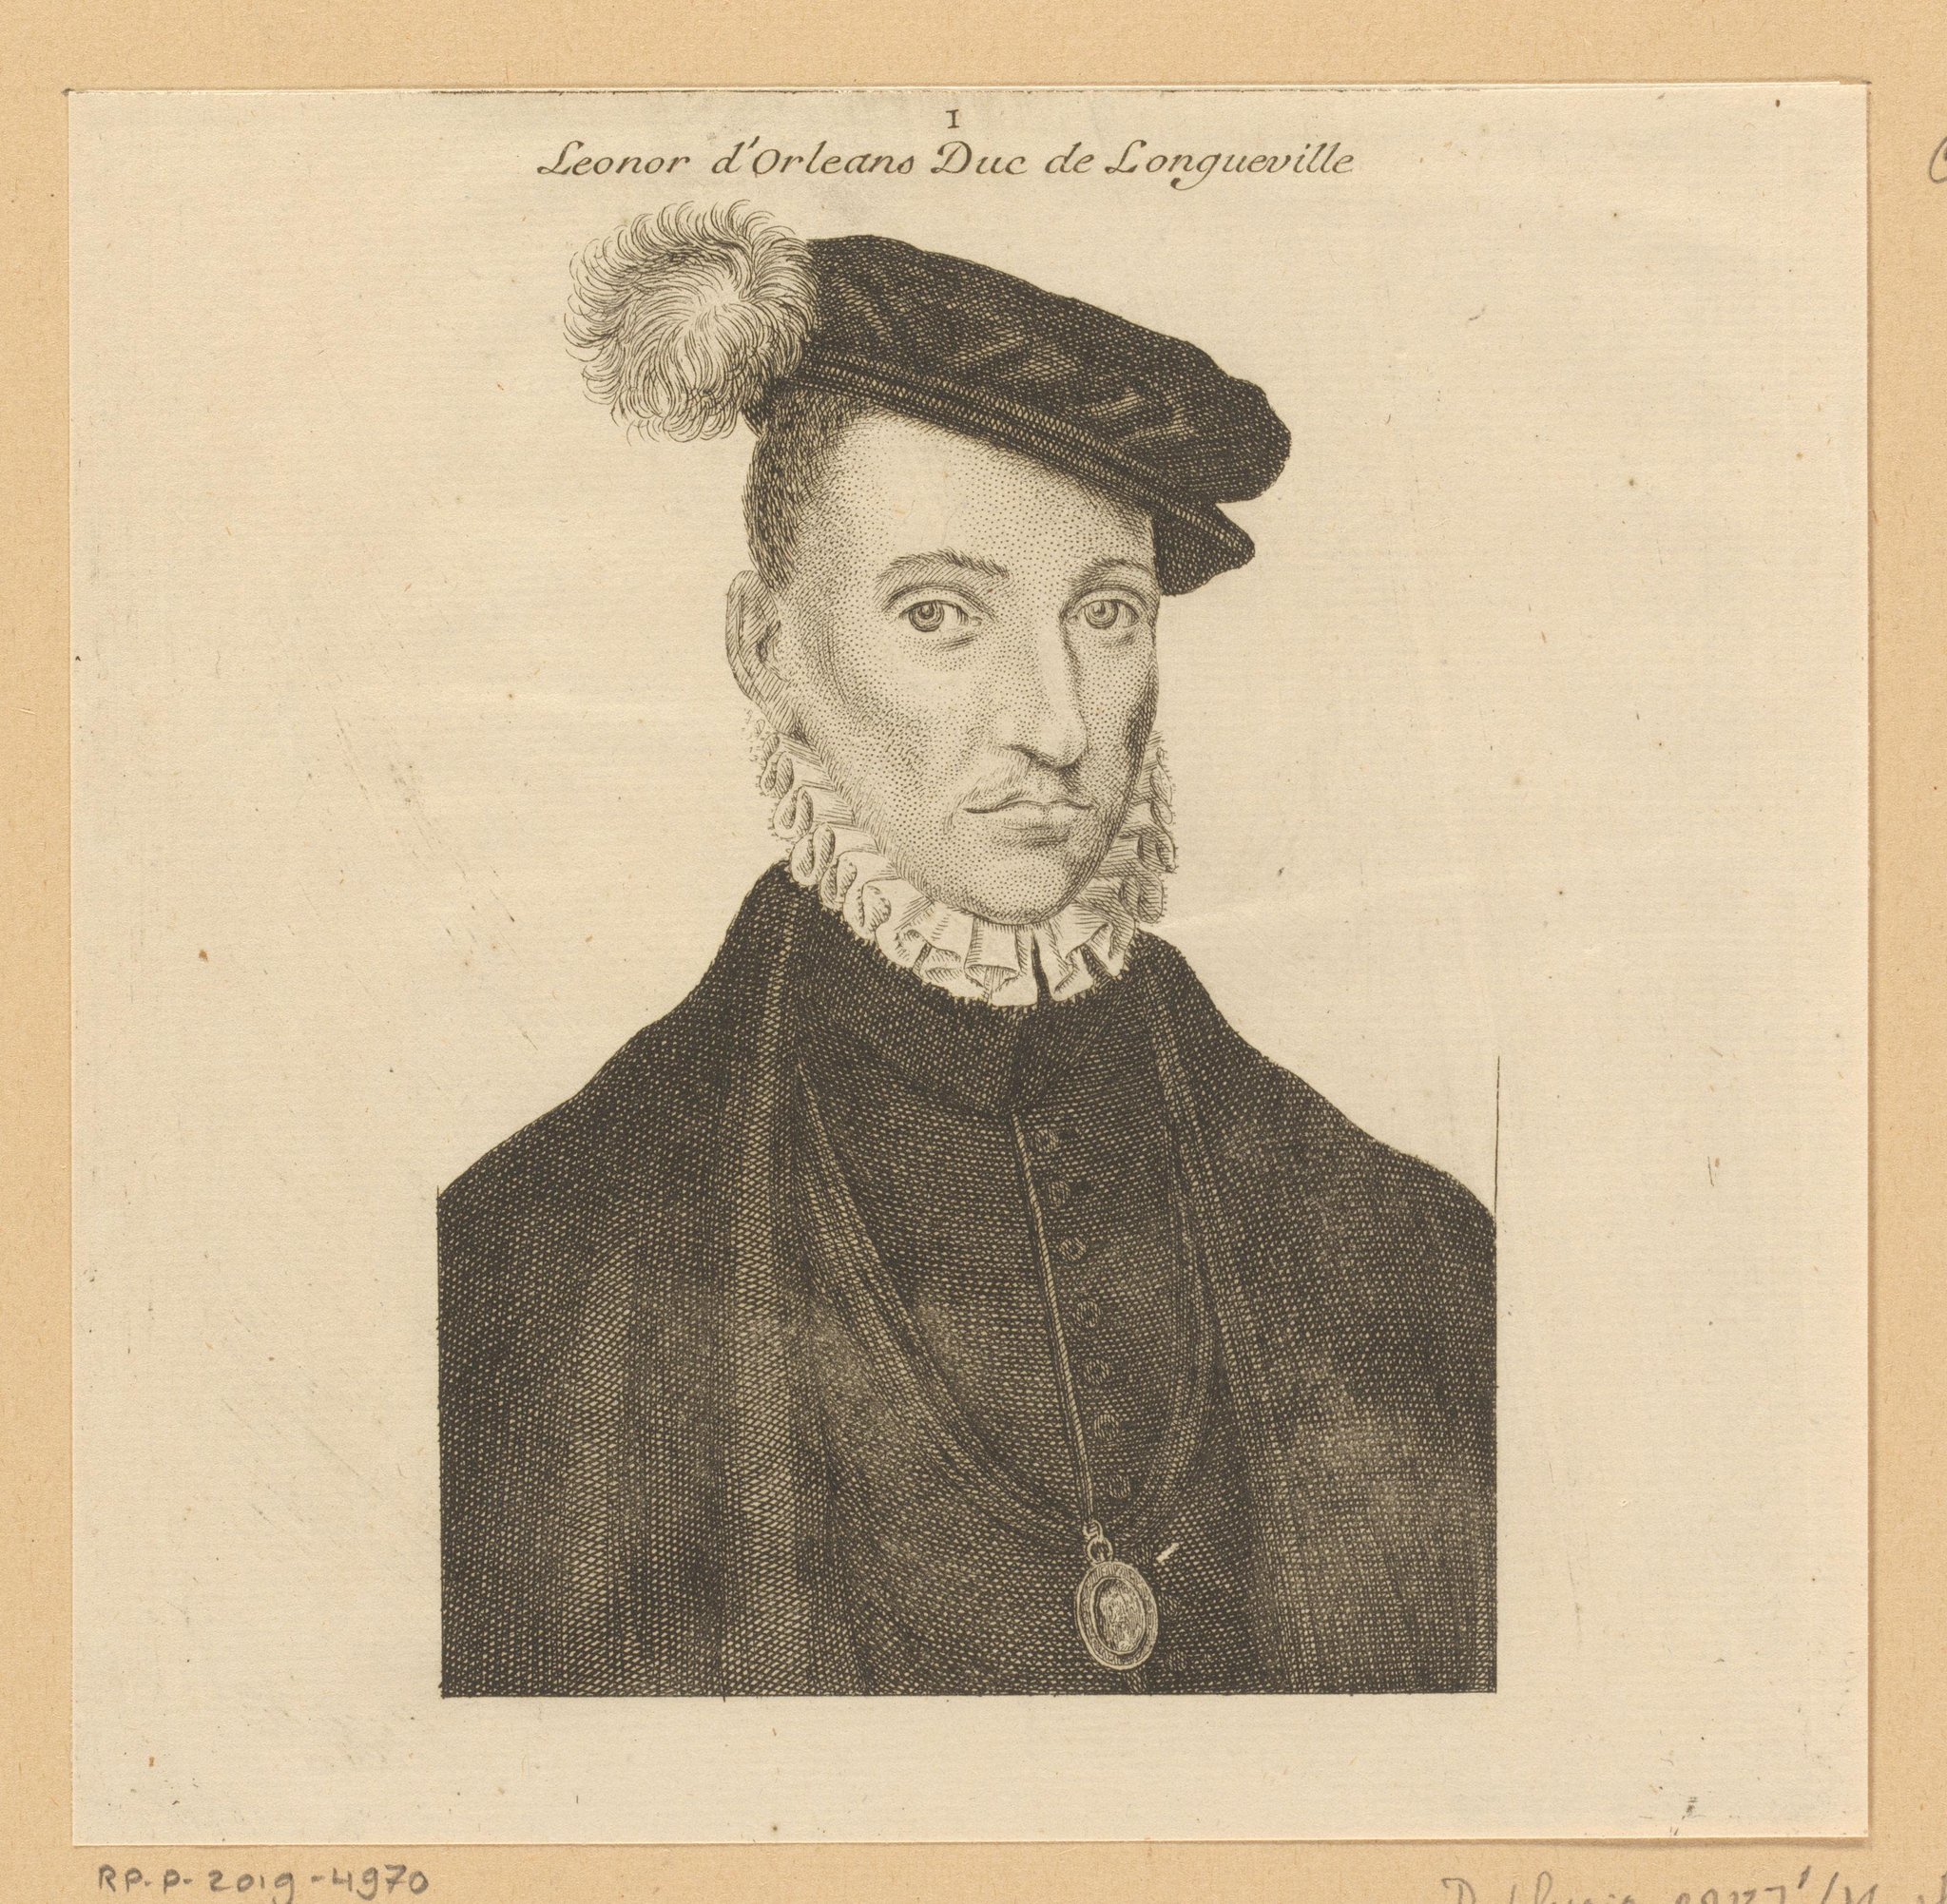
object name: book illustration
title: Portret van Léonor d'Orléans-Longueville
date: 1729-1733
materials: paper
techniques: etching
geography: paris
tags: historical persons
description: Prent uit: Montfaucon, Bernard de. Les monumens de la Monarchie Françoise (...). Parijs: Julien-Michel Gandouin en Pierre-François Giffart, 1729-1733.